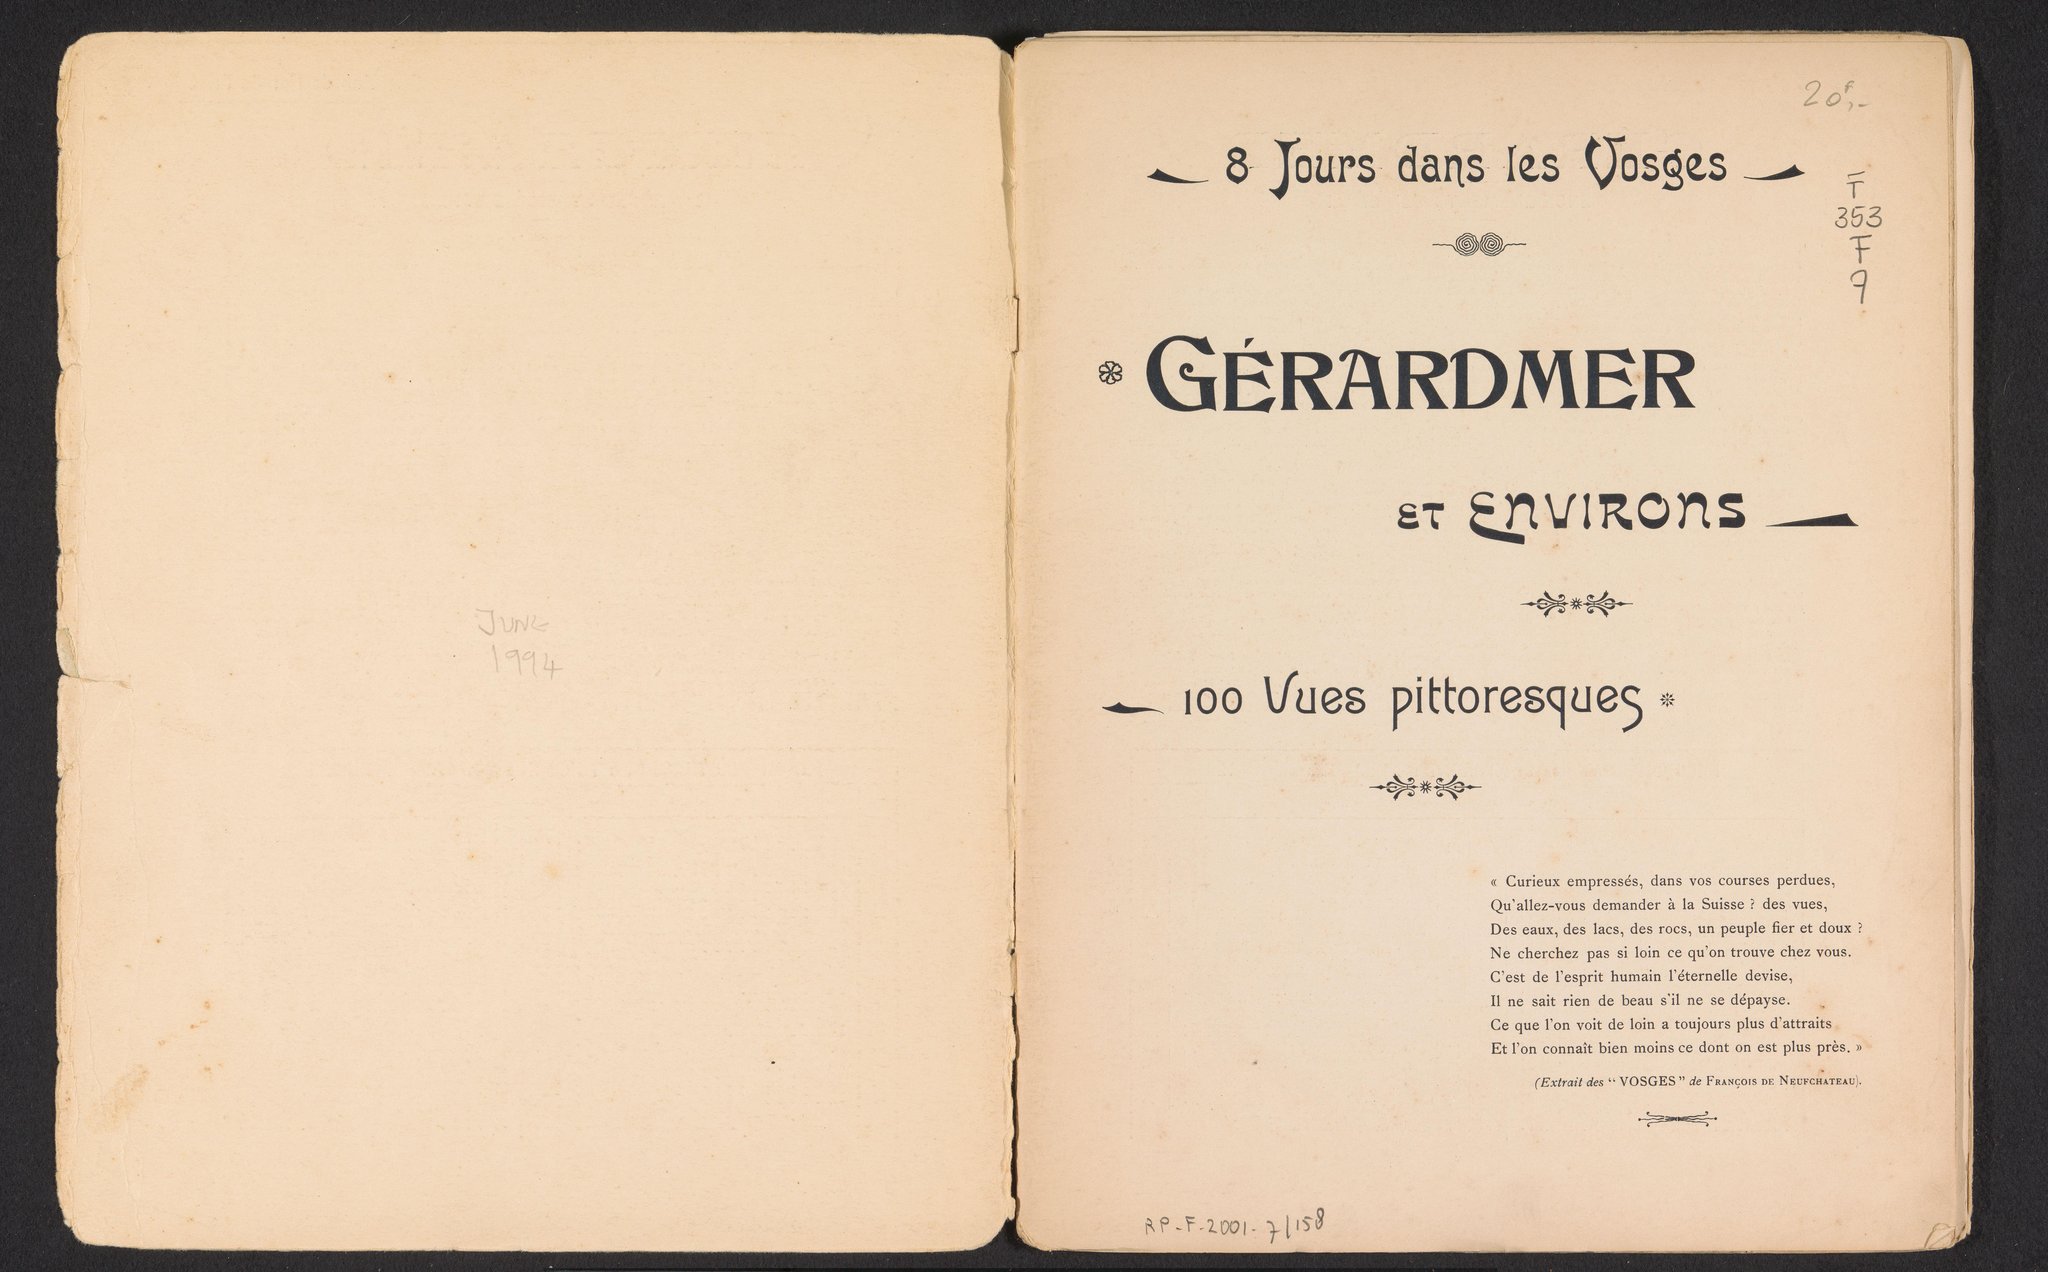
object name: book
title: 8 jours dans les Vosgues Gérardmer et environs 100 vues pittoresque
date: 1898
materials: paper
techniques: photograph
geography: nancy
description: Op het voorplat vier lichtdrukken van de natuur in de Vogezen. Op het achterplat twee lichtdrukken van gebouwen.